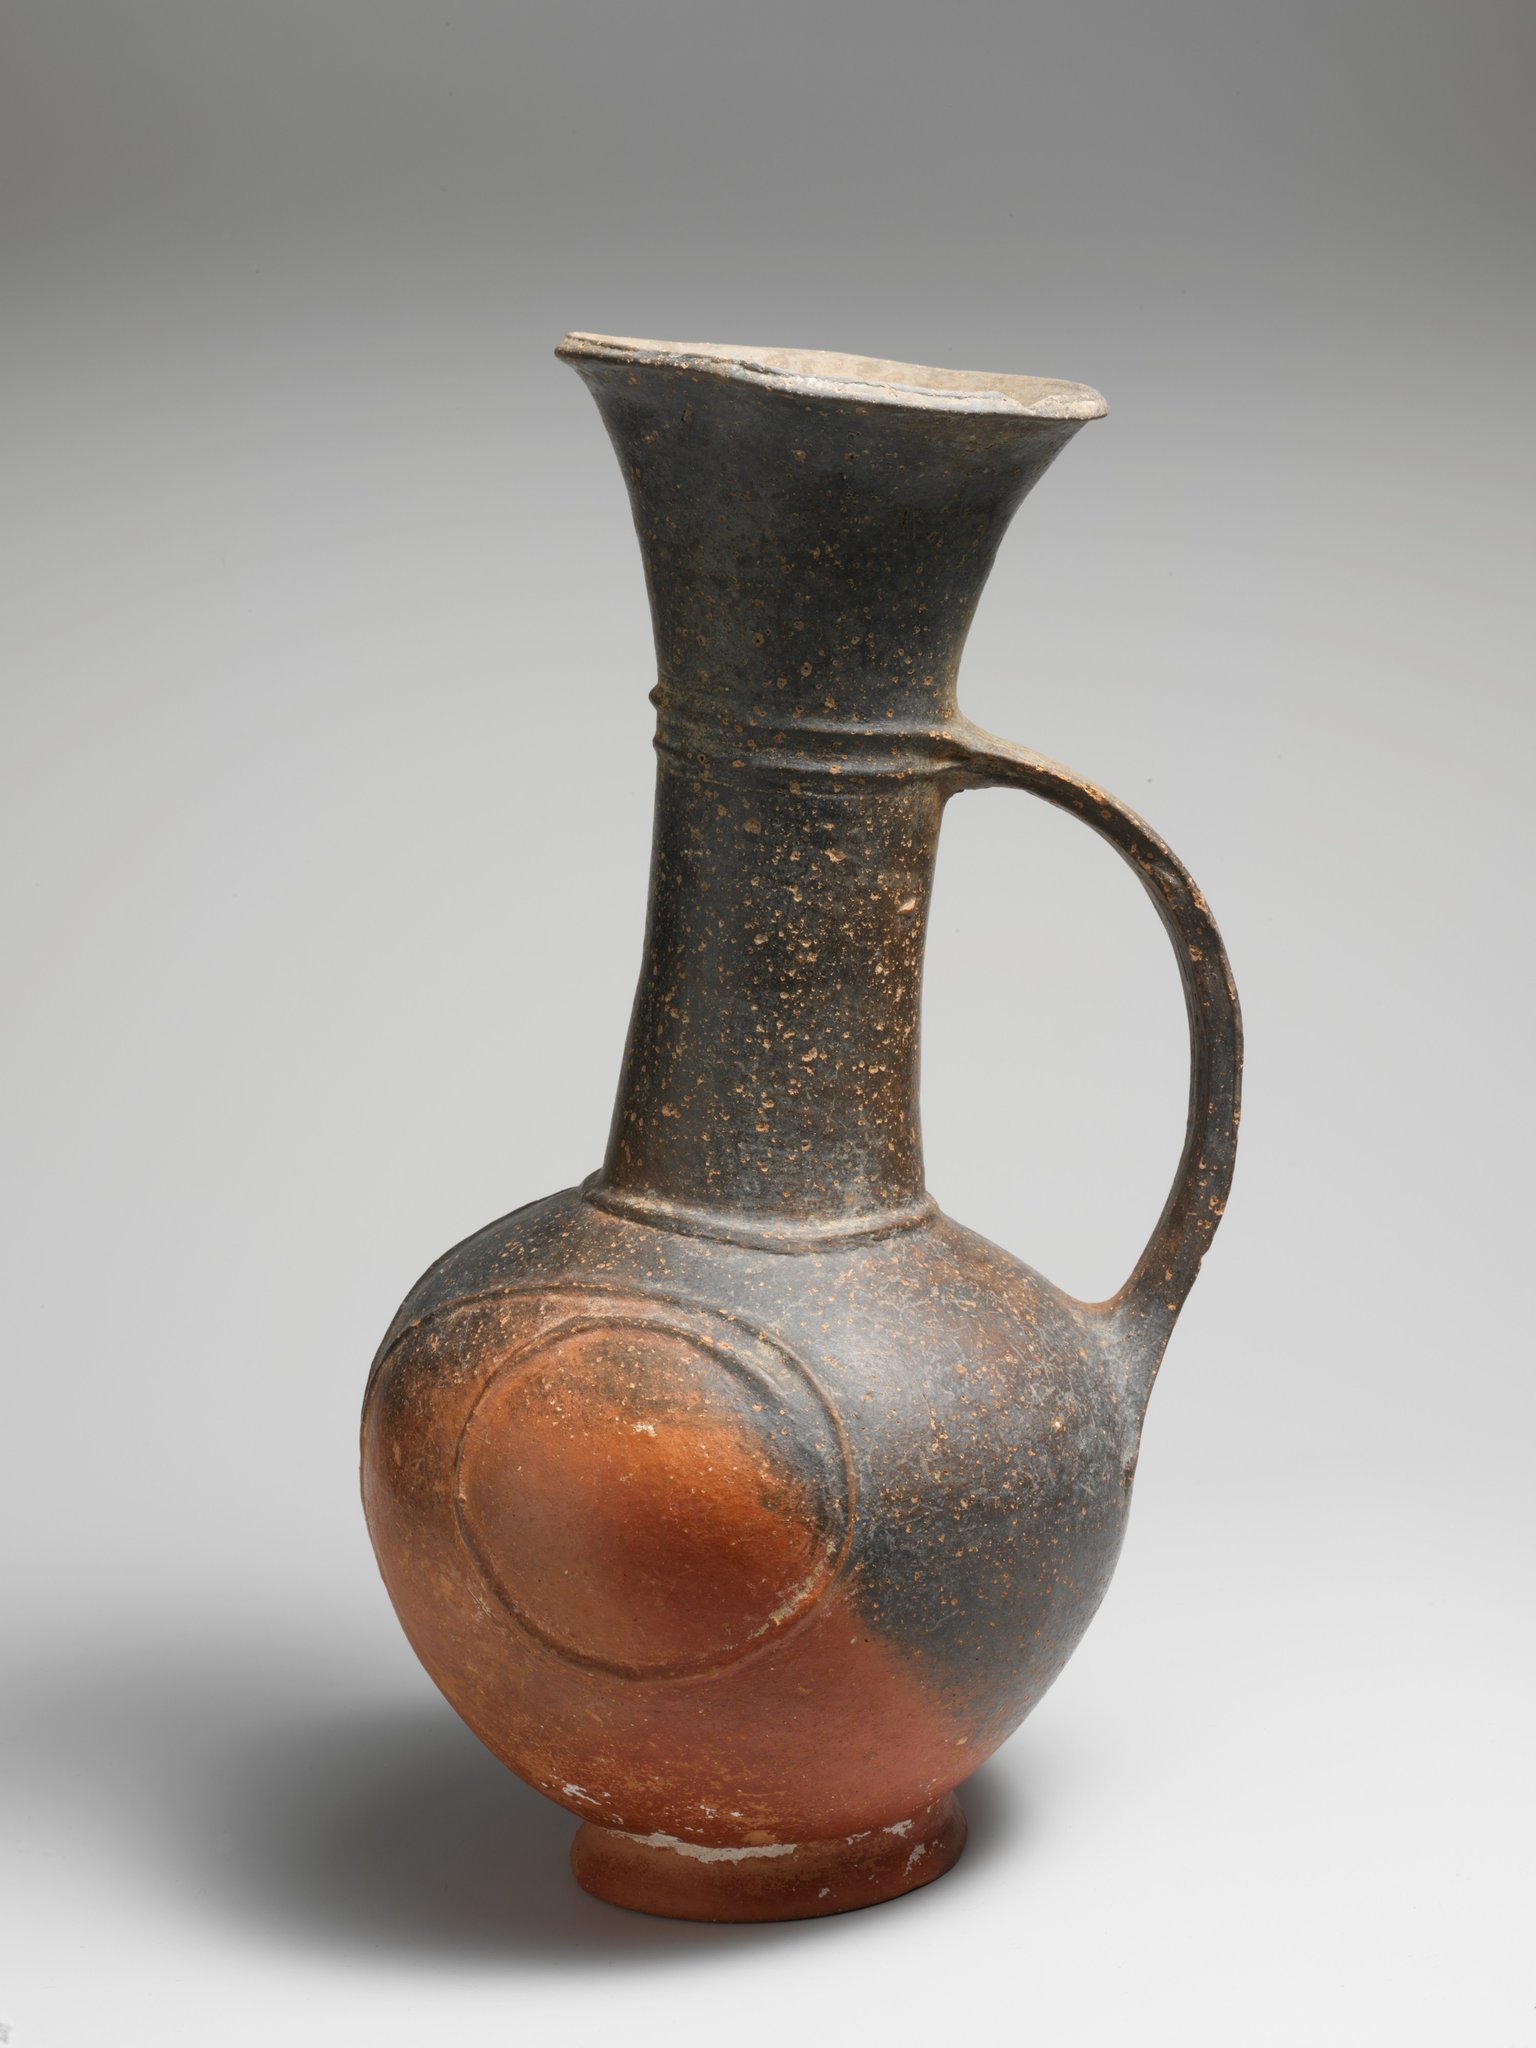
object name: jug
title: Terracotta jug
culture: cypriot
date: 1600-1450 BCE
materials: terracotta